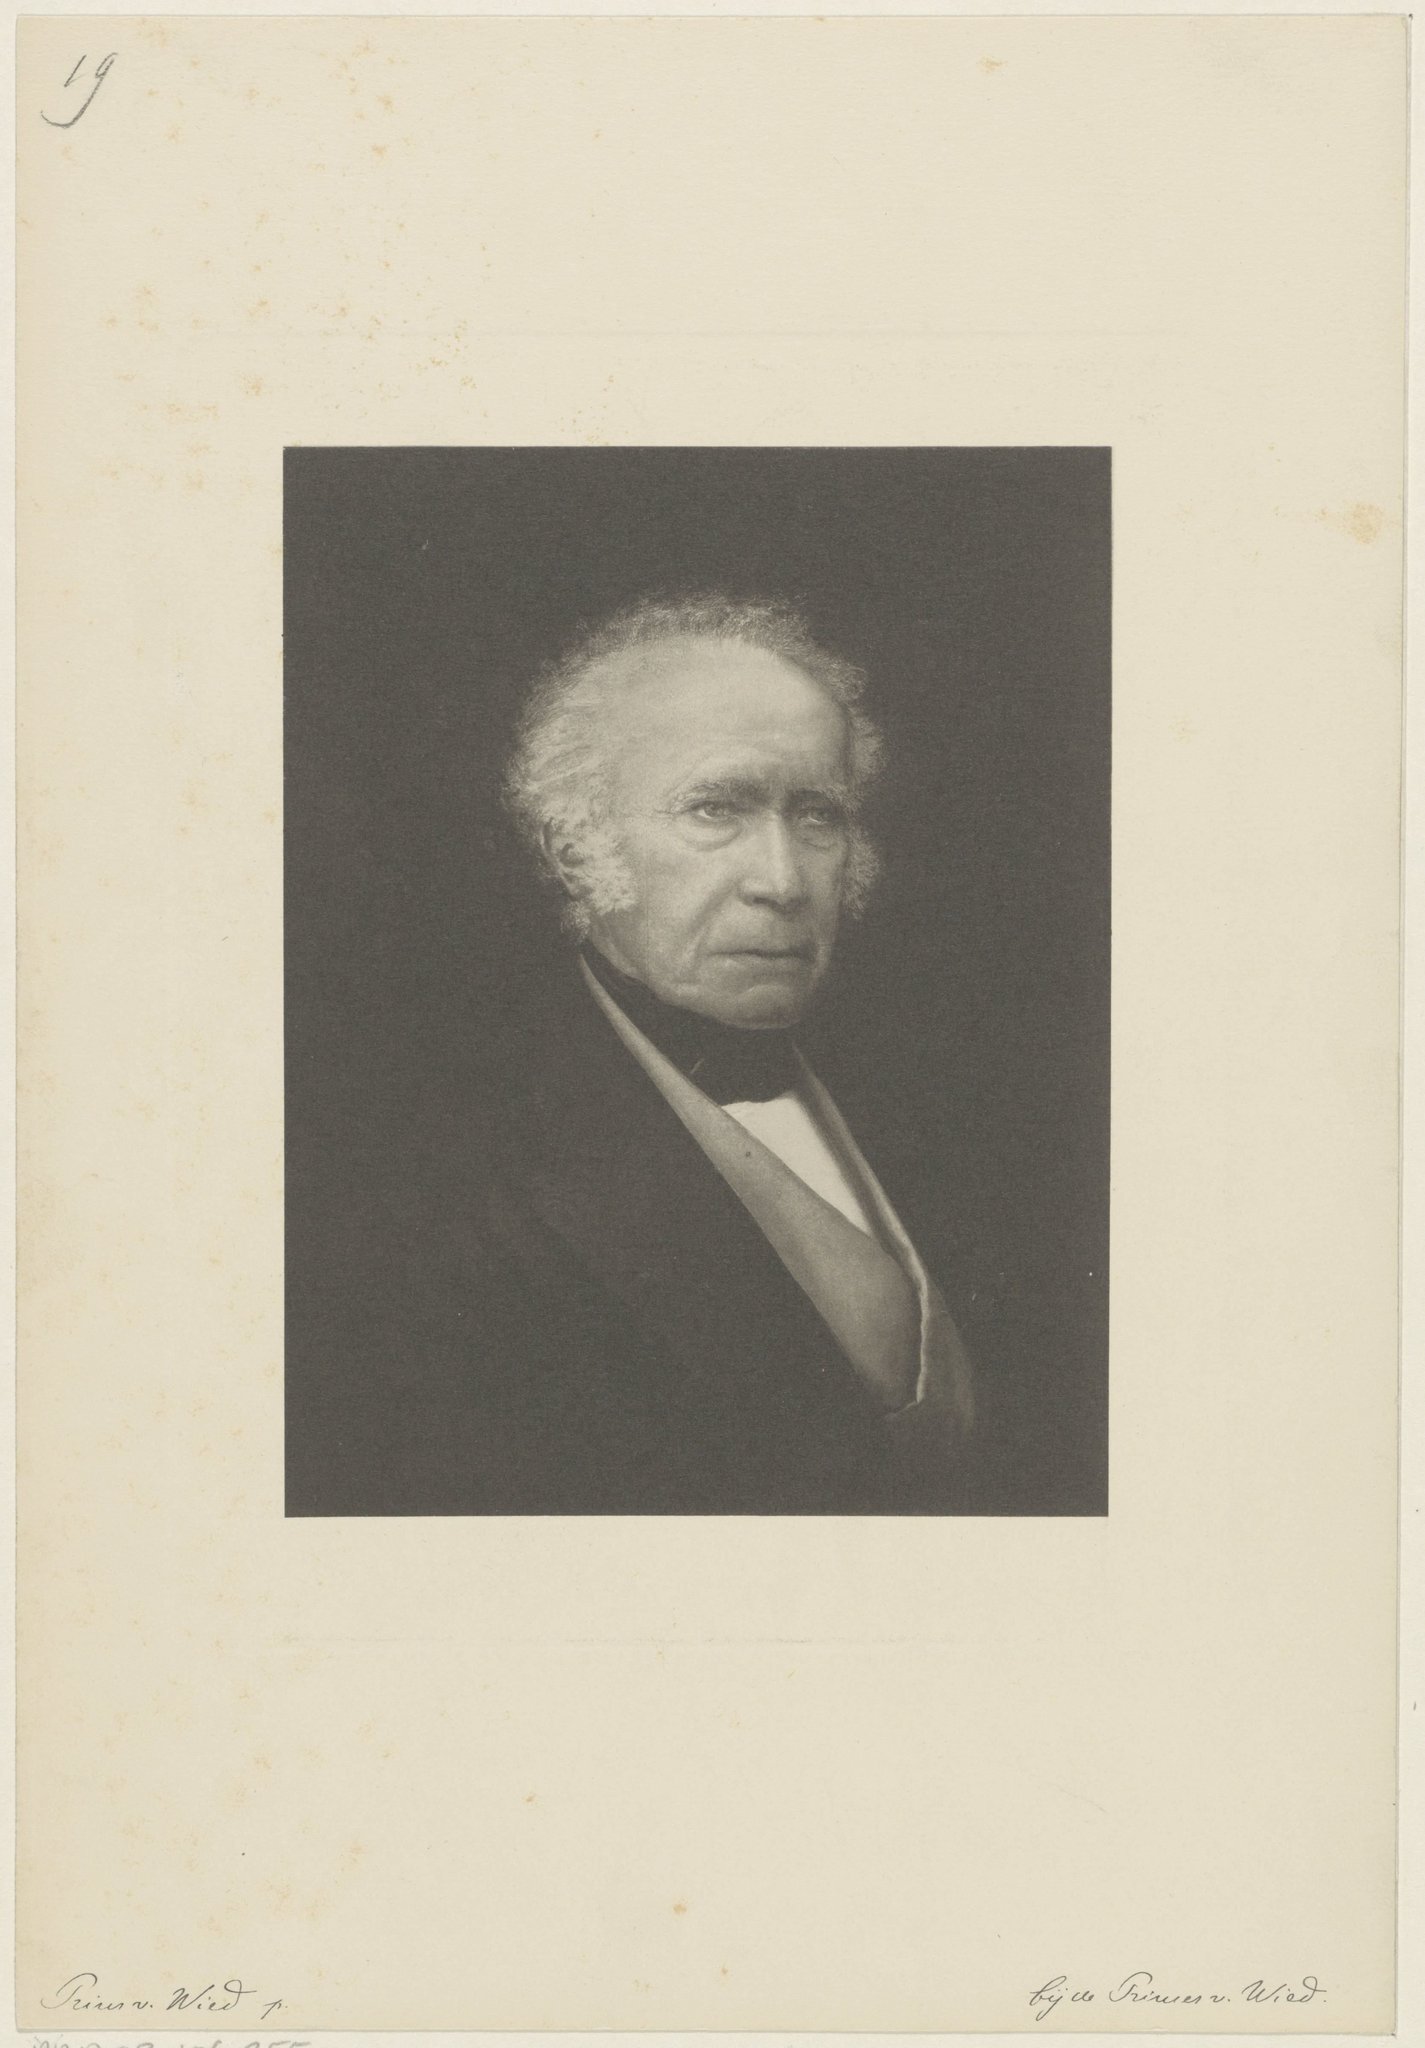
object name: photomechanical print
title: Portret van Frederik, prins der Nederlanden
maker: Anonymous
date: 1870-1949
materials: paper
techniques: photograph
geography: netherlands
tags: frederik (prins der nederlanden)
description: De hier vermelde titel verwijst naar de hoogst verkregen titel van de geportretteerde, niet per se naar de titel die de geportretteerde op deze voorstelling draagt.